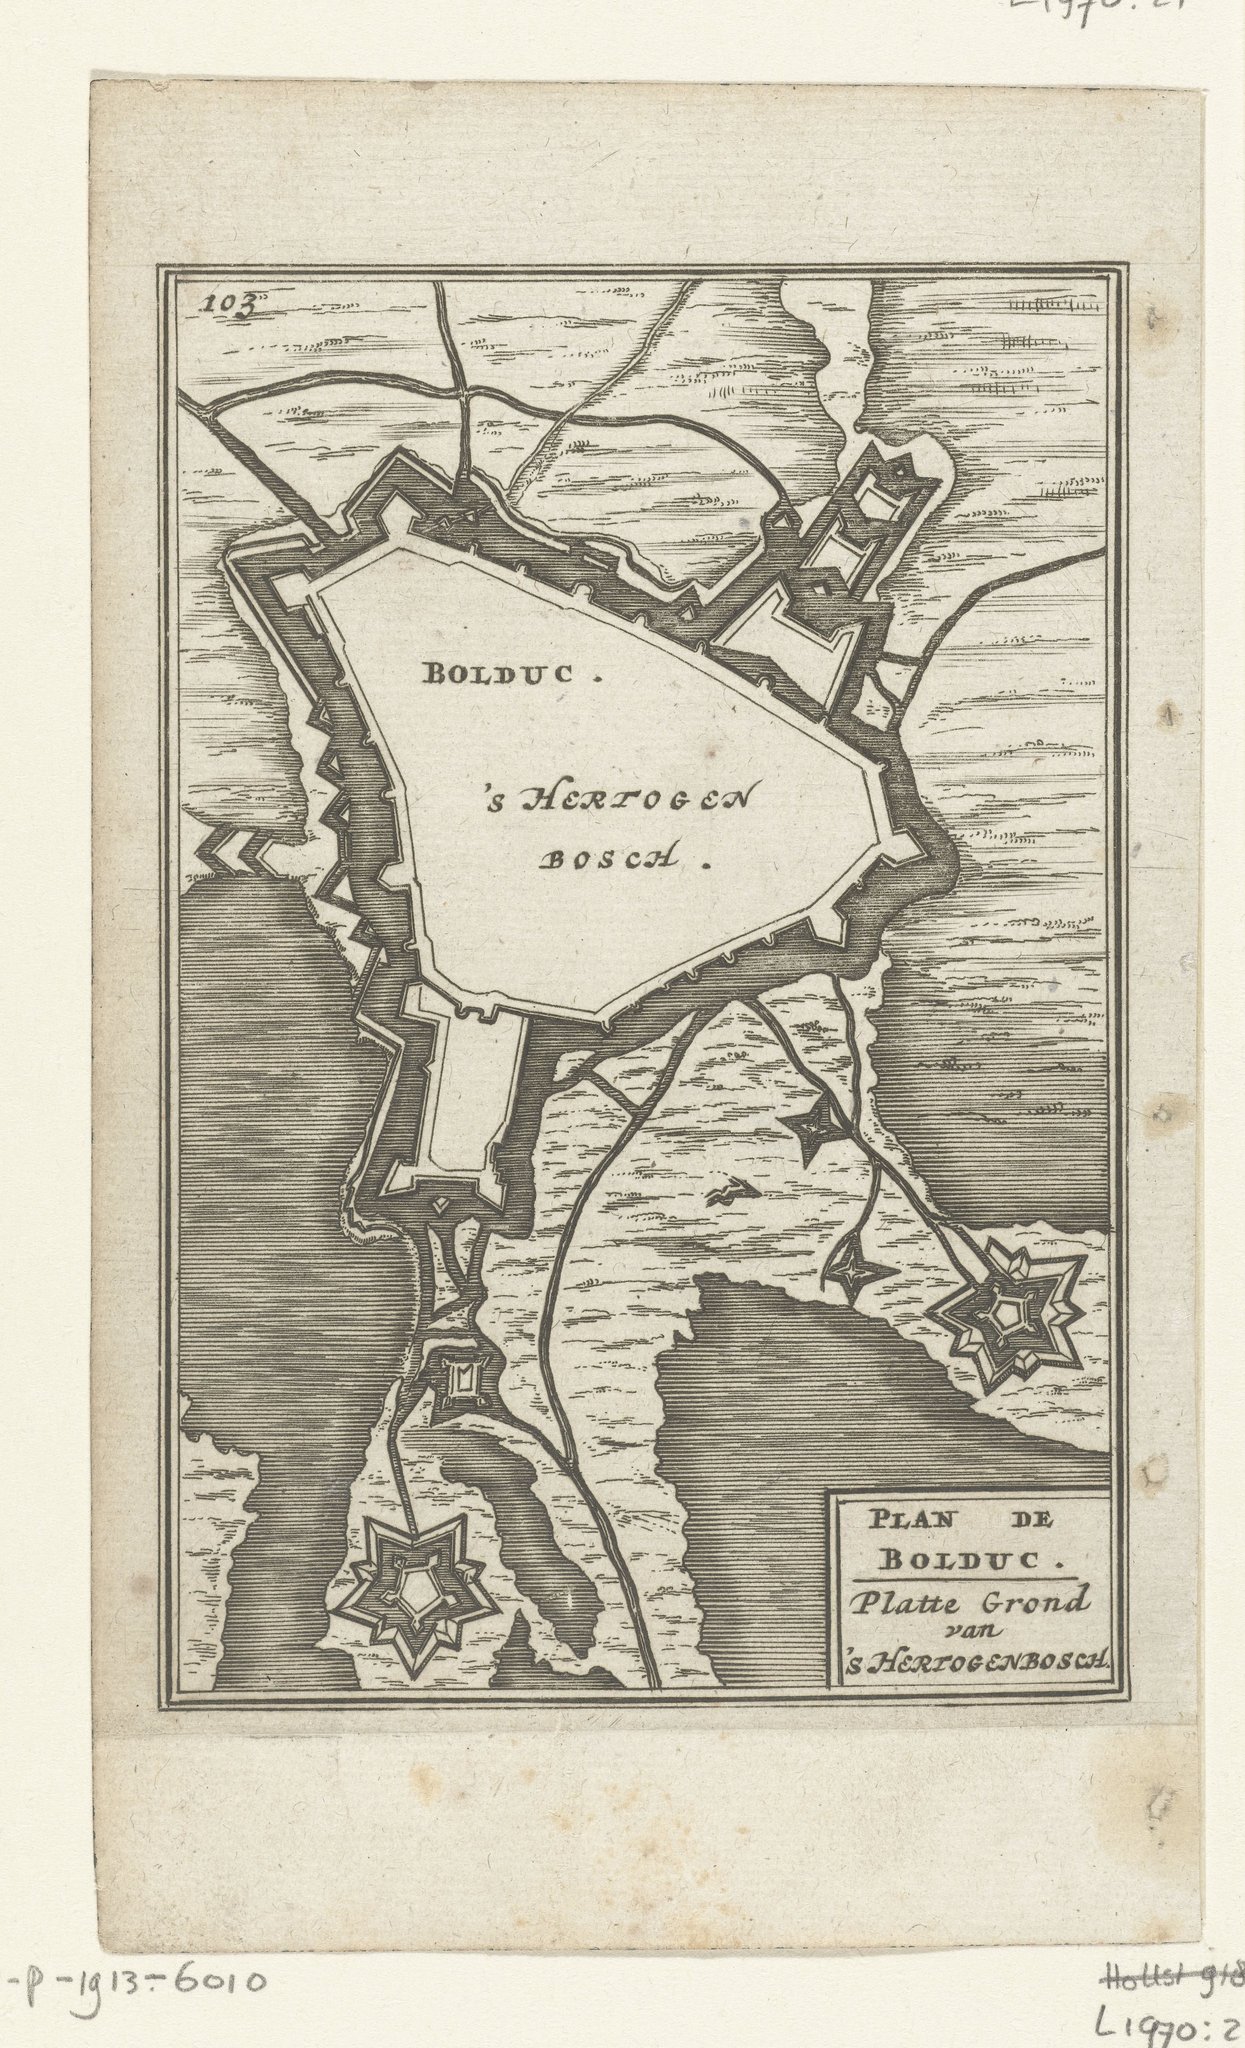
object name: book illustration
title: Illustratie voor 'Den Arbeid van Mars' van Allain Manesson Mallet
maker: romeyn de hooghe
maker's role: draughtsman, goldsmith, painter, print maker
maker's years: 1645-1708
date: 1672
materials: paper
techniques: engraving, etching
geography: amsterdam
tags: city-view in general; 'veduta', fortifications, military engineering, den bosch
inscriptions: collector's mark: Lugt 2228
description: Illustratie voor: Allain Manesson Mallet, 'Den Arbeid van Mars' (3 delen, Amsterdam: Jacob van Meurs of Amsterdam: Jacob van Meurs en Johannes (I) Janssonius van Waesberge, 1672). Klinkert, C.